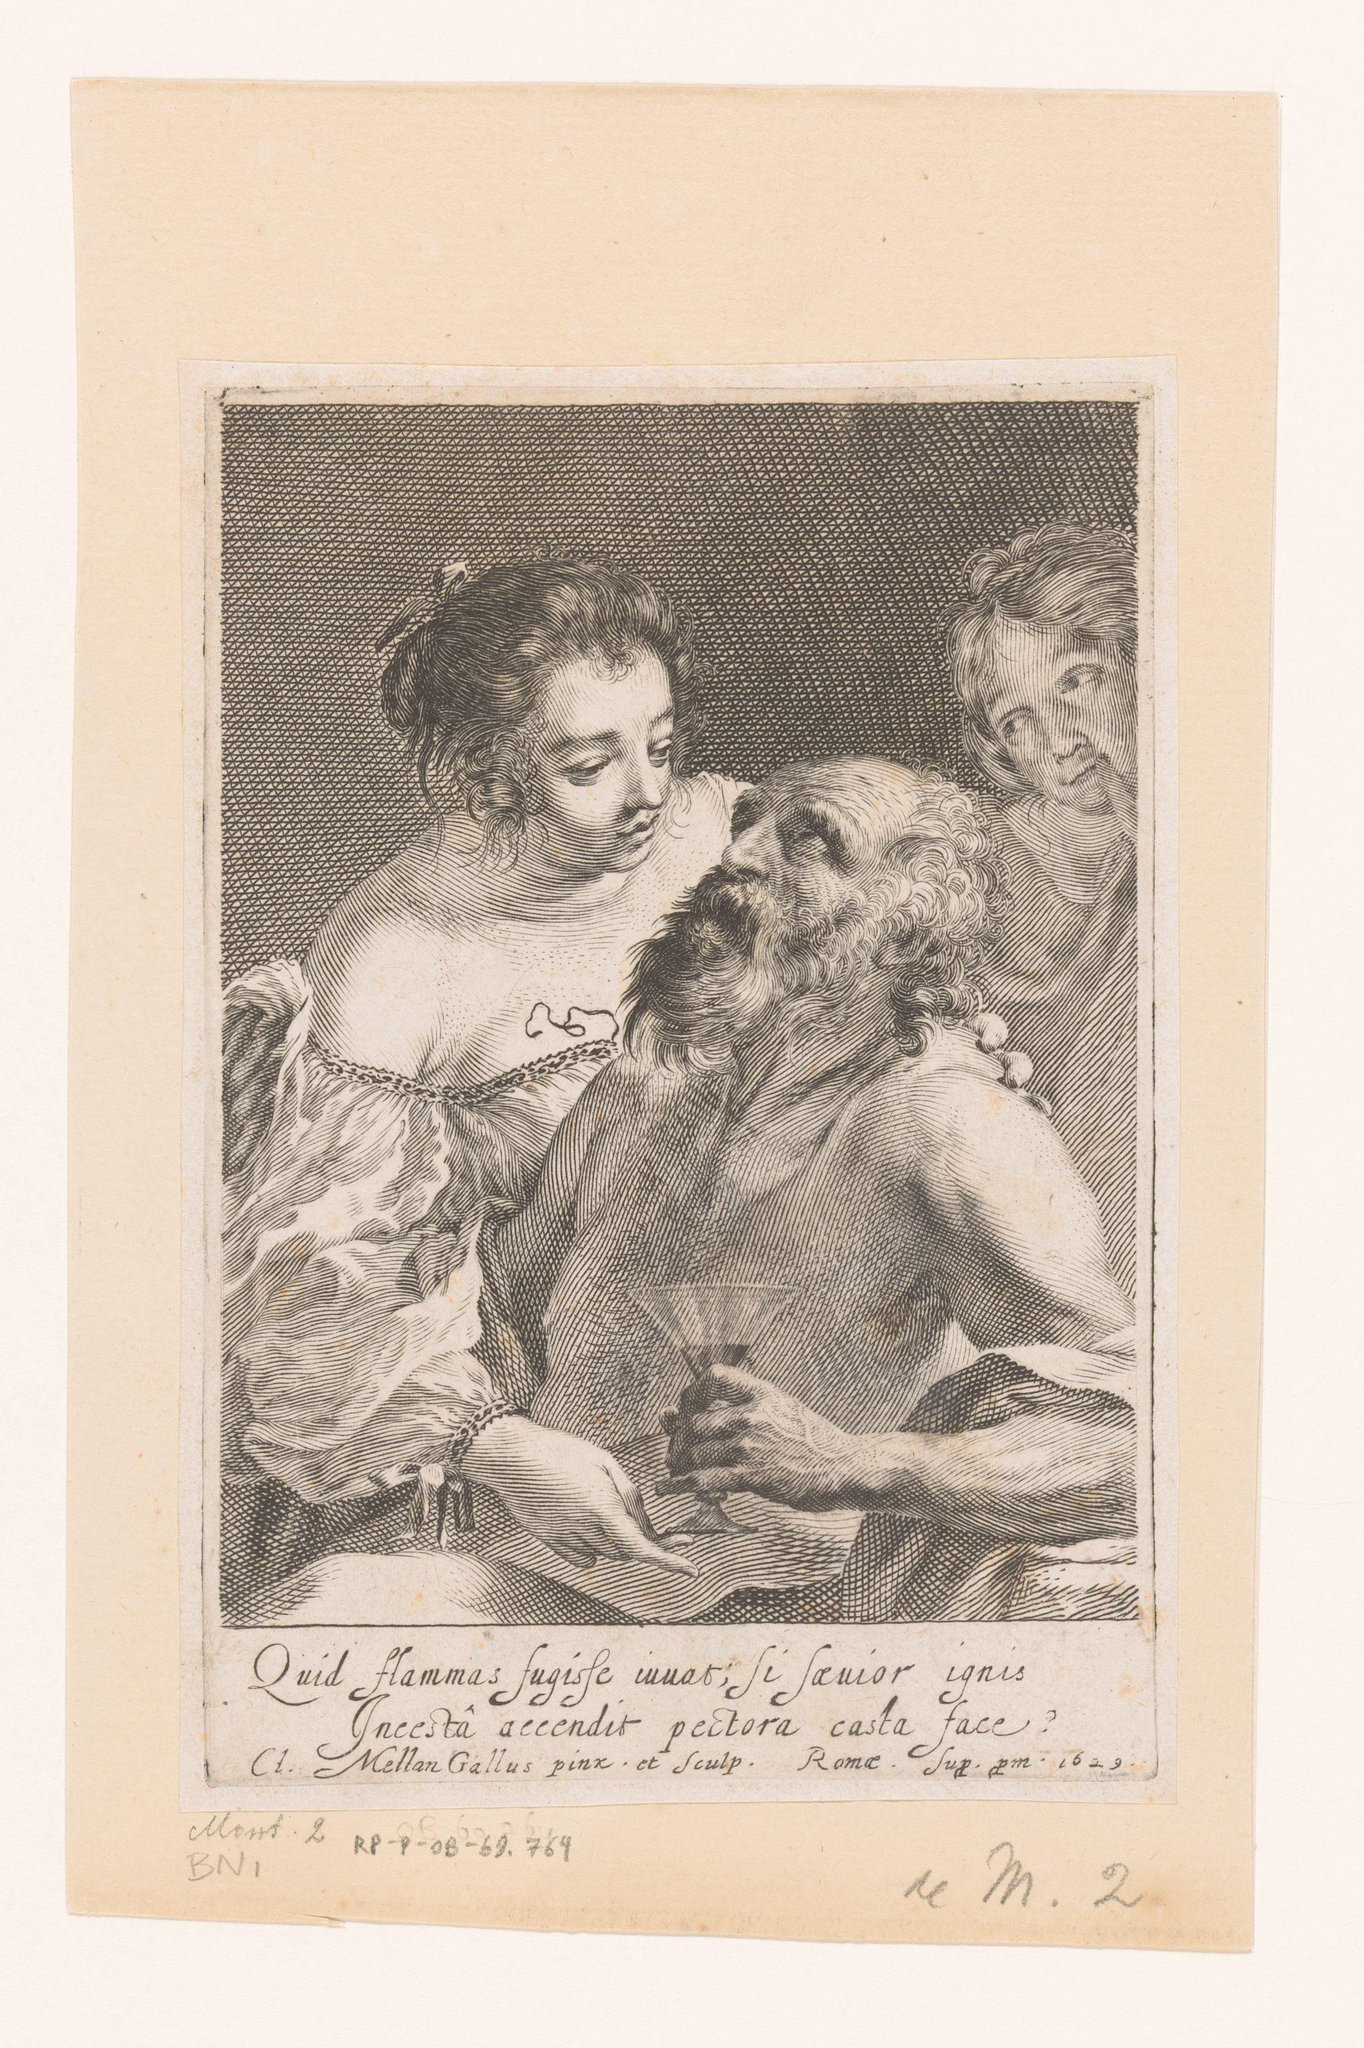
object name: print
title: Lot en zijn dochters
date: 1629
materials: paper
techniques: engraving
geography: italy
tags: lot and his daughters (genesis 19:30-38)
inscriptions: collector's mark: Lugt 240